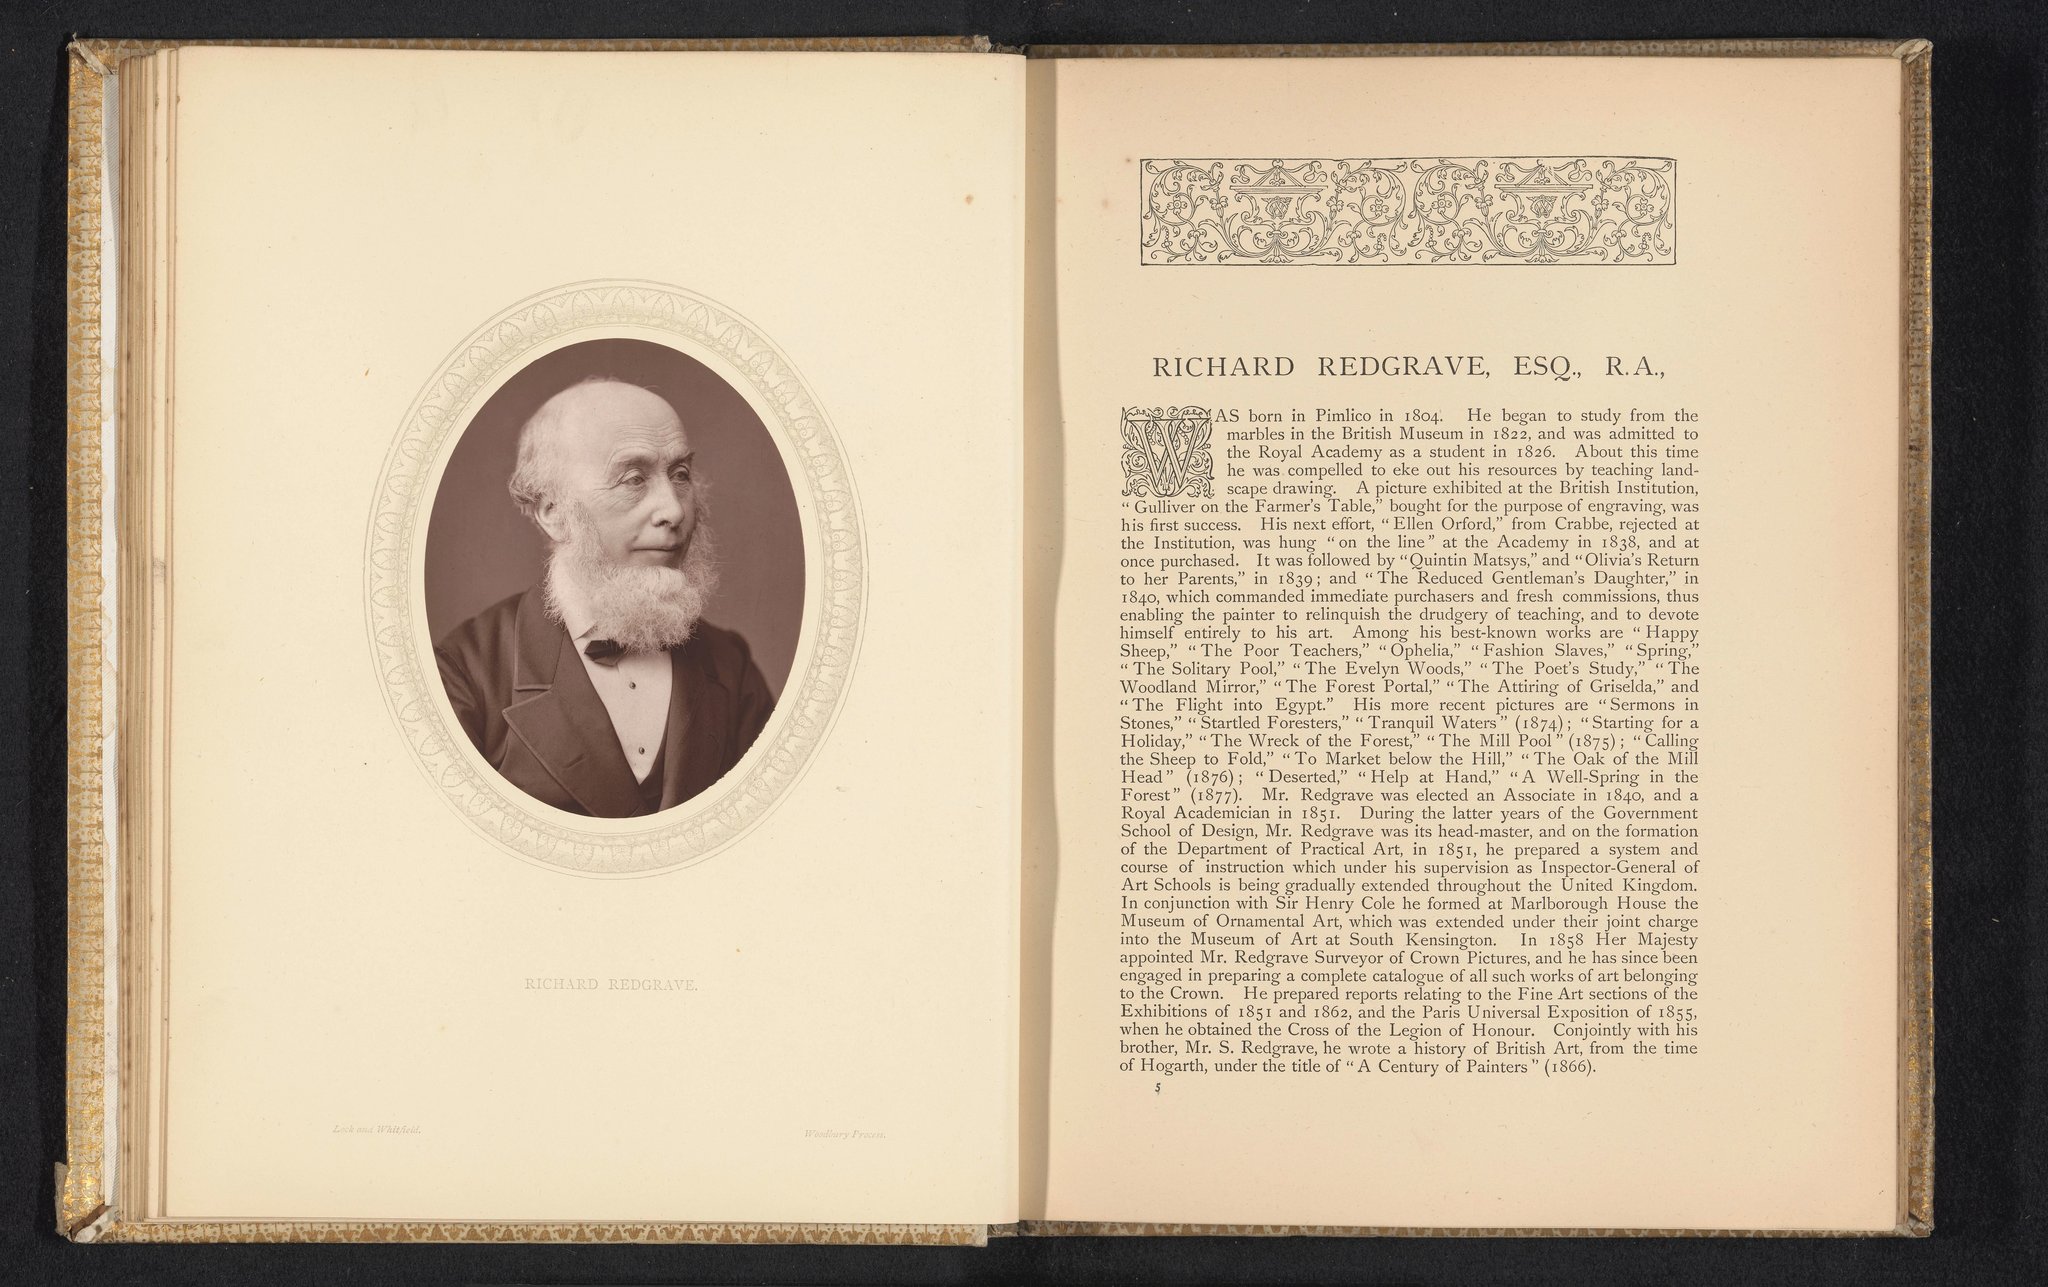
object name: photomechanical print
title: Richard Redgrave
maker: Anonymous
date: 1873-1878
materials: paper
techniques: woodburytype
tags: artist, richard redgrave, historical persons (portraits and scenes from the life) (+ (full) bust portrait), portrait, self-portrait of artist